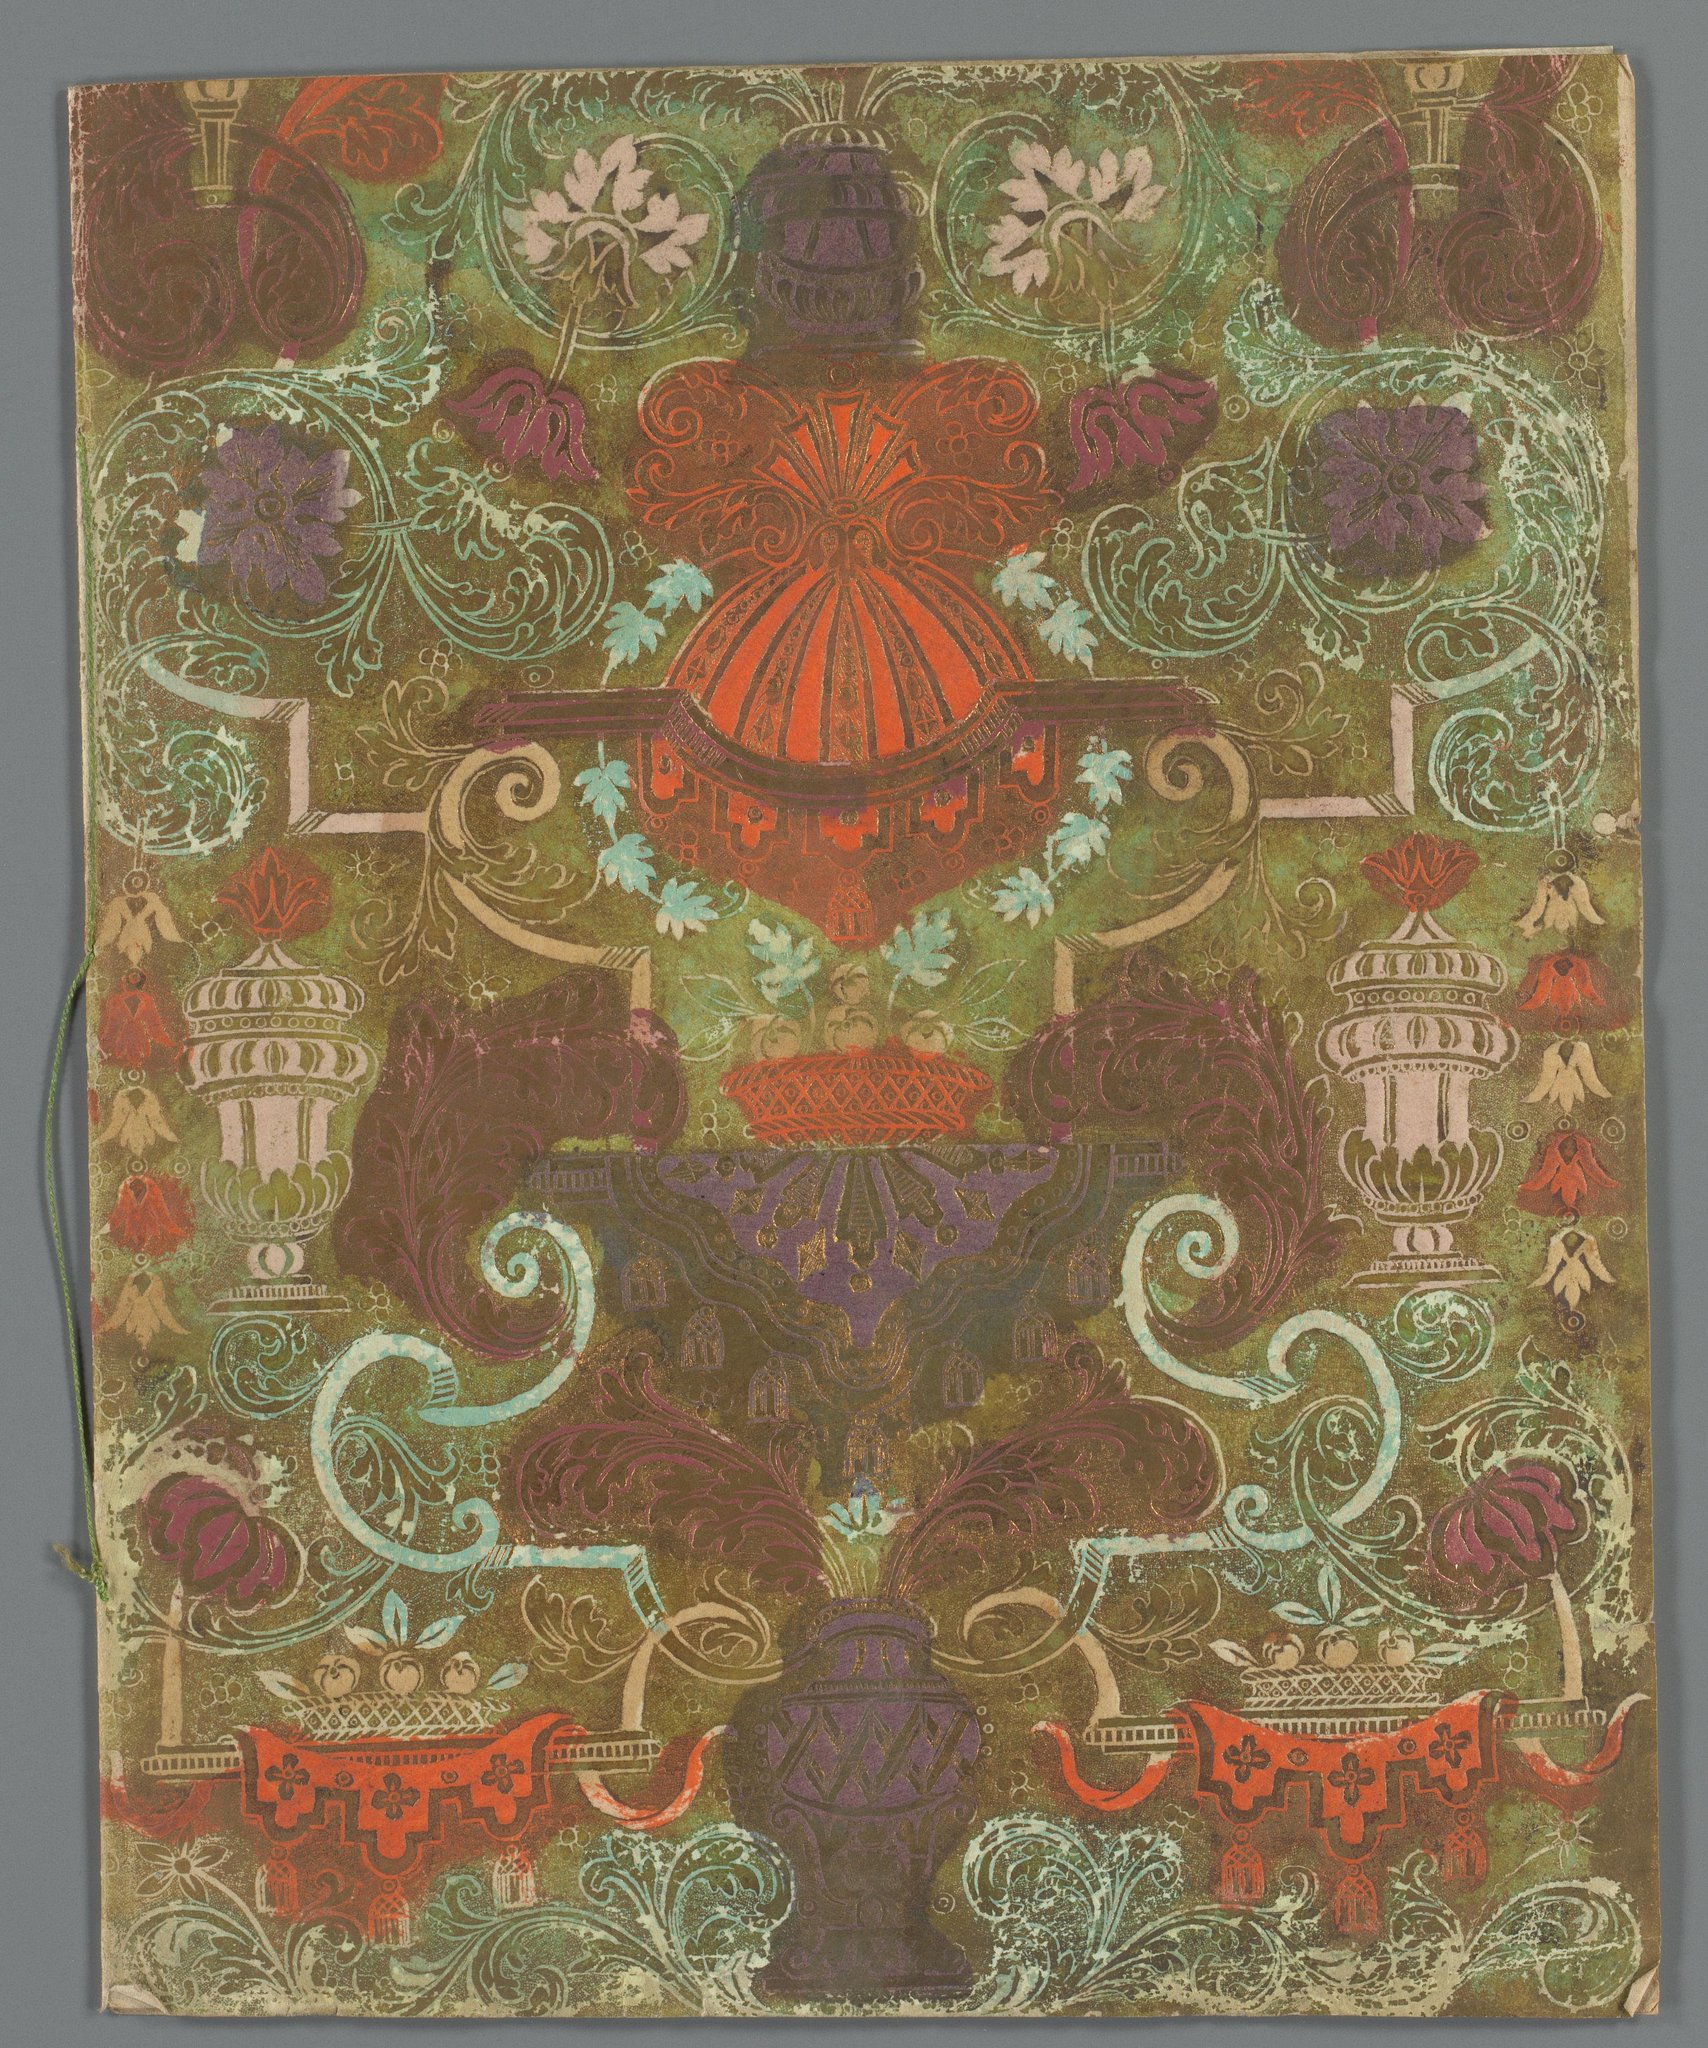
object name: book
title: Ter bruylofte van den Heer en Mr. Samuel Thiens, en Juffrouw Ester Maria Cocq, in den Echt vereenigt binnen Amersfoort den 30 December 1720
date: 1720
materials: paper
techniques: bookbinding, letterpress printing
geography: middelie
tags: satire on marriage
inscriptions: date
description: Tekst uitgesproken in de kerk door C.H. van Heimenberg, tijdens de bruiloft op 30 december 1720 in Amersfoort. Acht pagina's tekst in een omslag van brokaatpapier. Op het titelblad het drukkersvignet, en een gedecoreerd initiaal W aan het begin van de tekst.